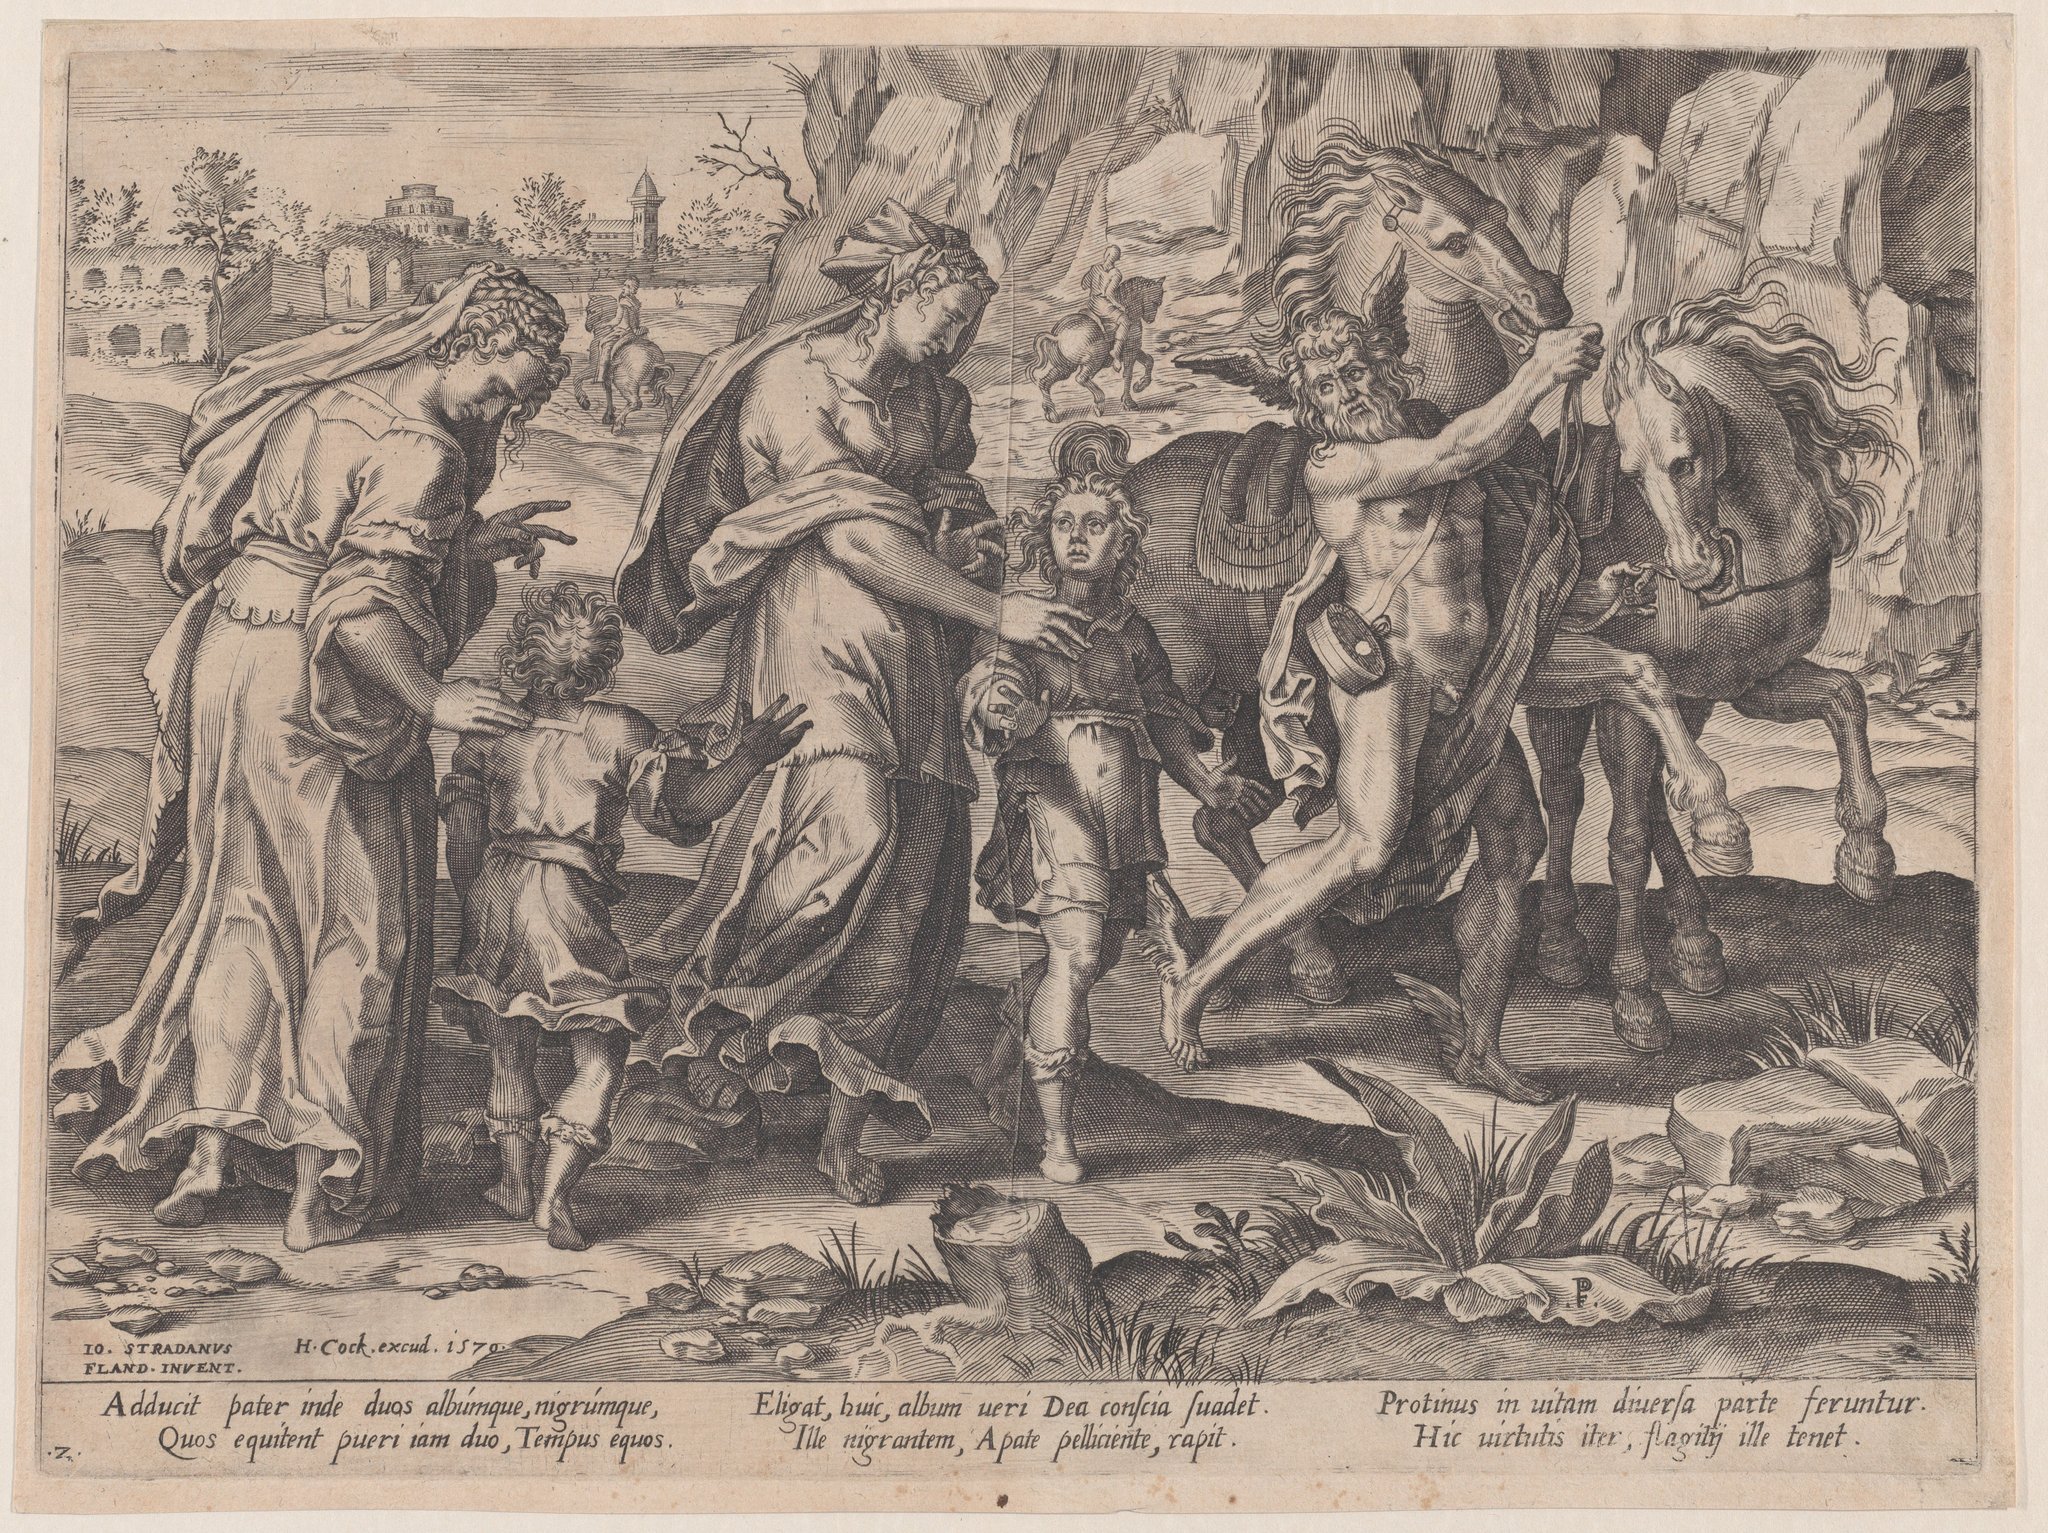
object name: print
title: Youth, from "The Course of Human Life"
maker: pieter jalhea furnius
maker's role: artist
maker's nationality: flemish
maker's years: 1545-1610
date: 1570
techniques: engraving